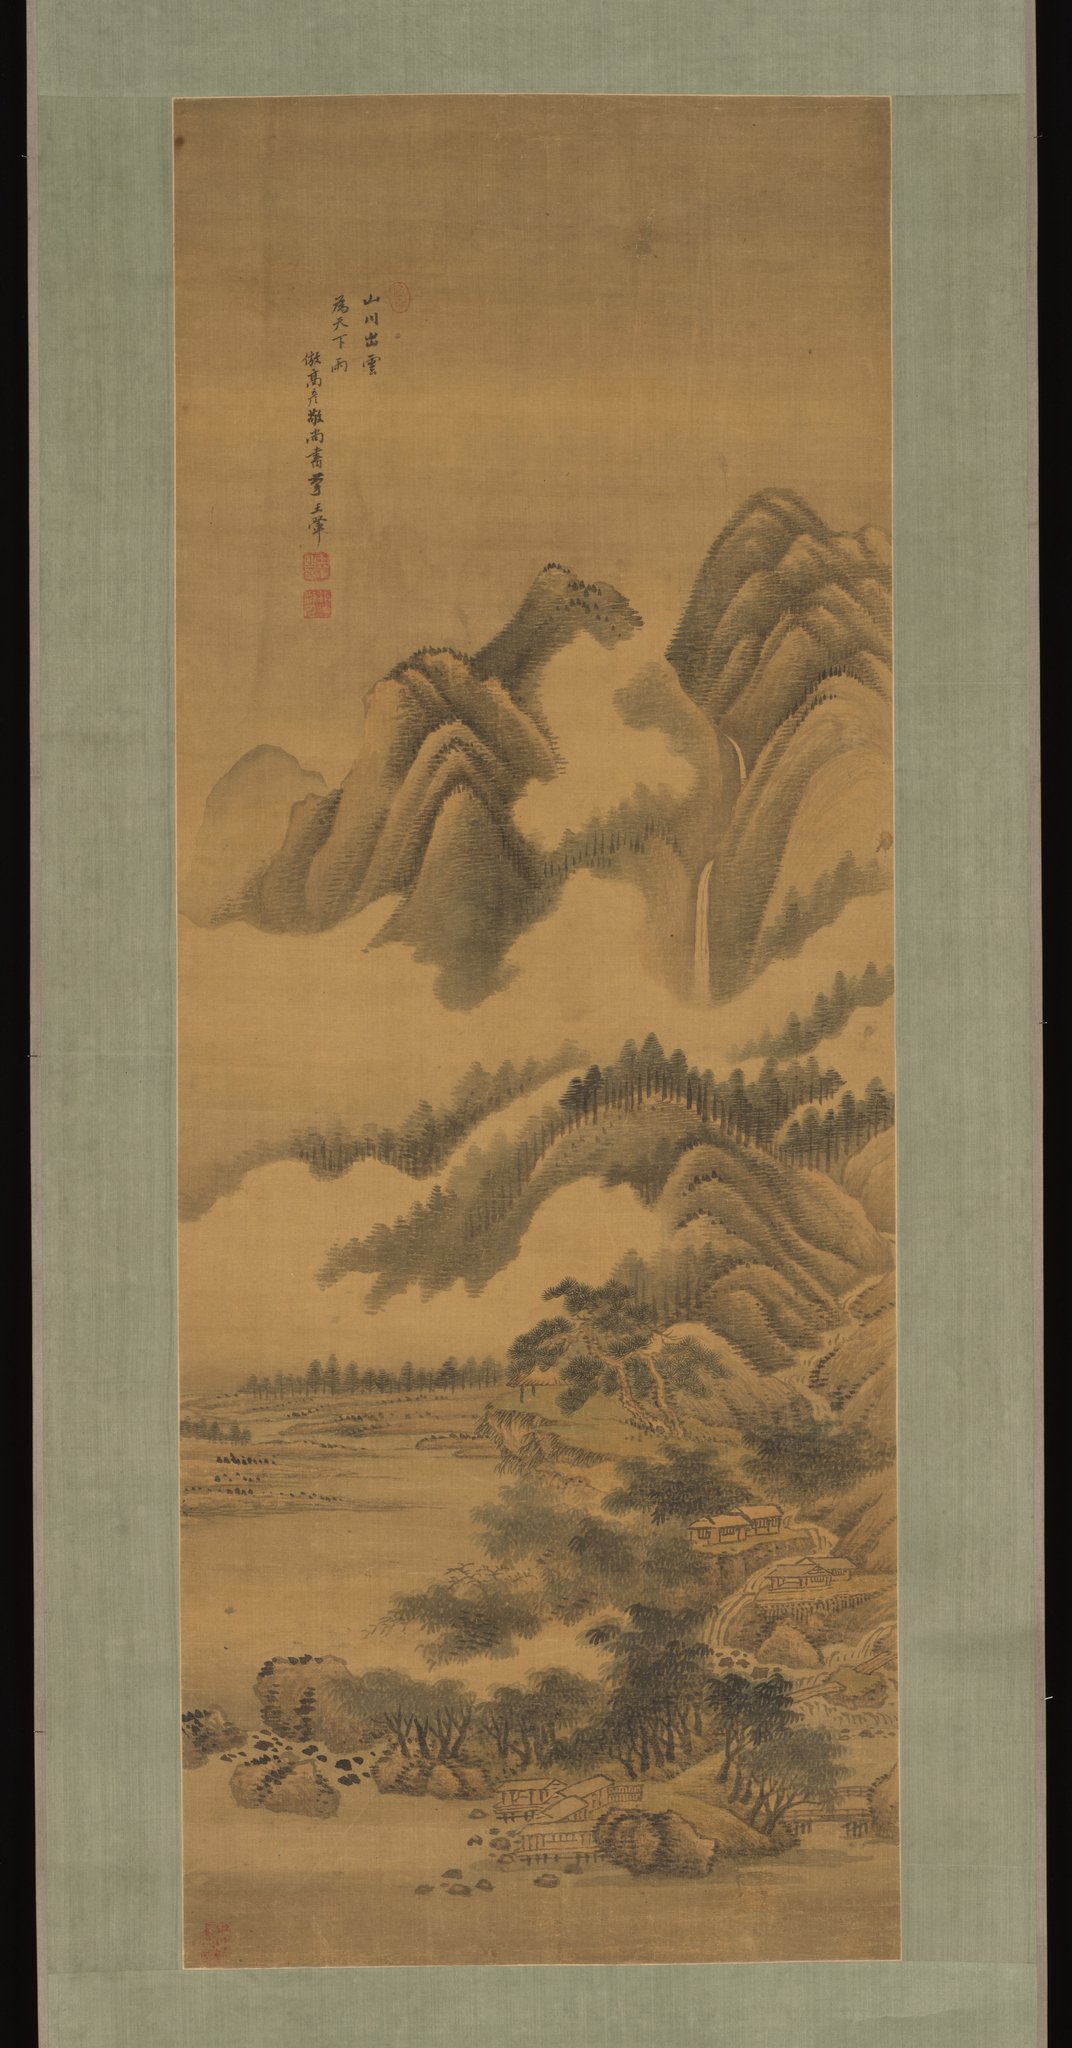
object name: hanging scroll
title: Landscape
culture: chinese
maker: unidentified artist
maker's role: artist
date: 1644-1911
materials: silk